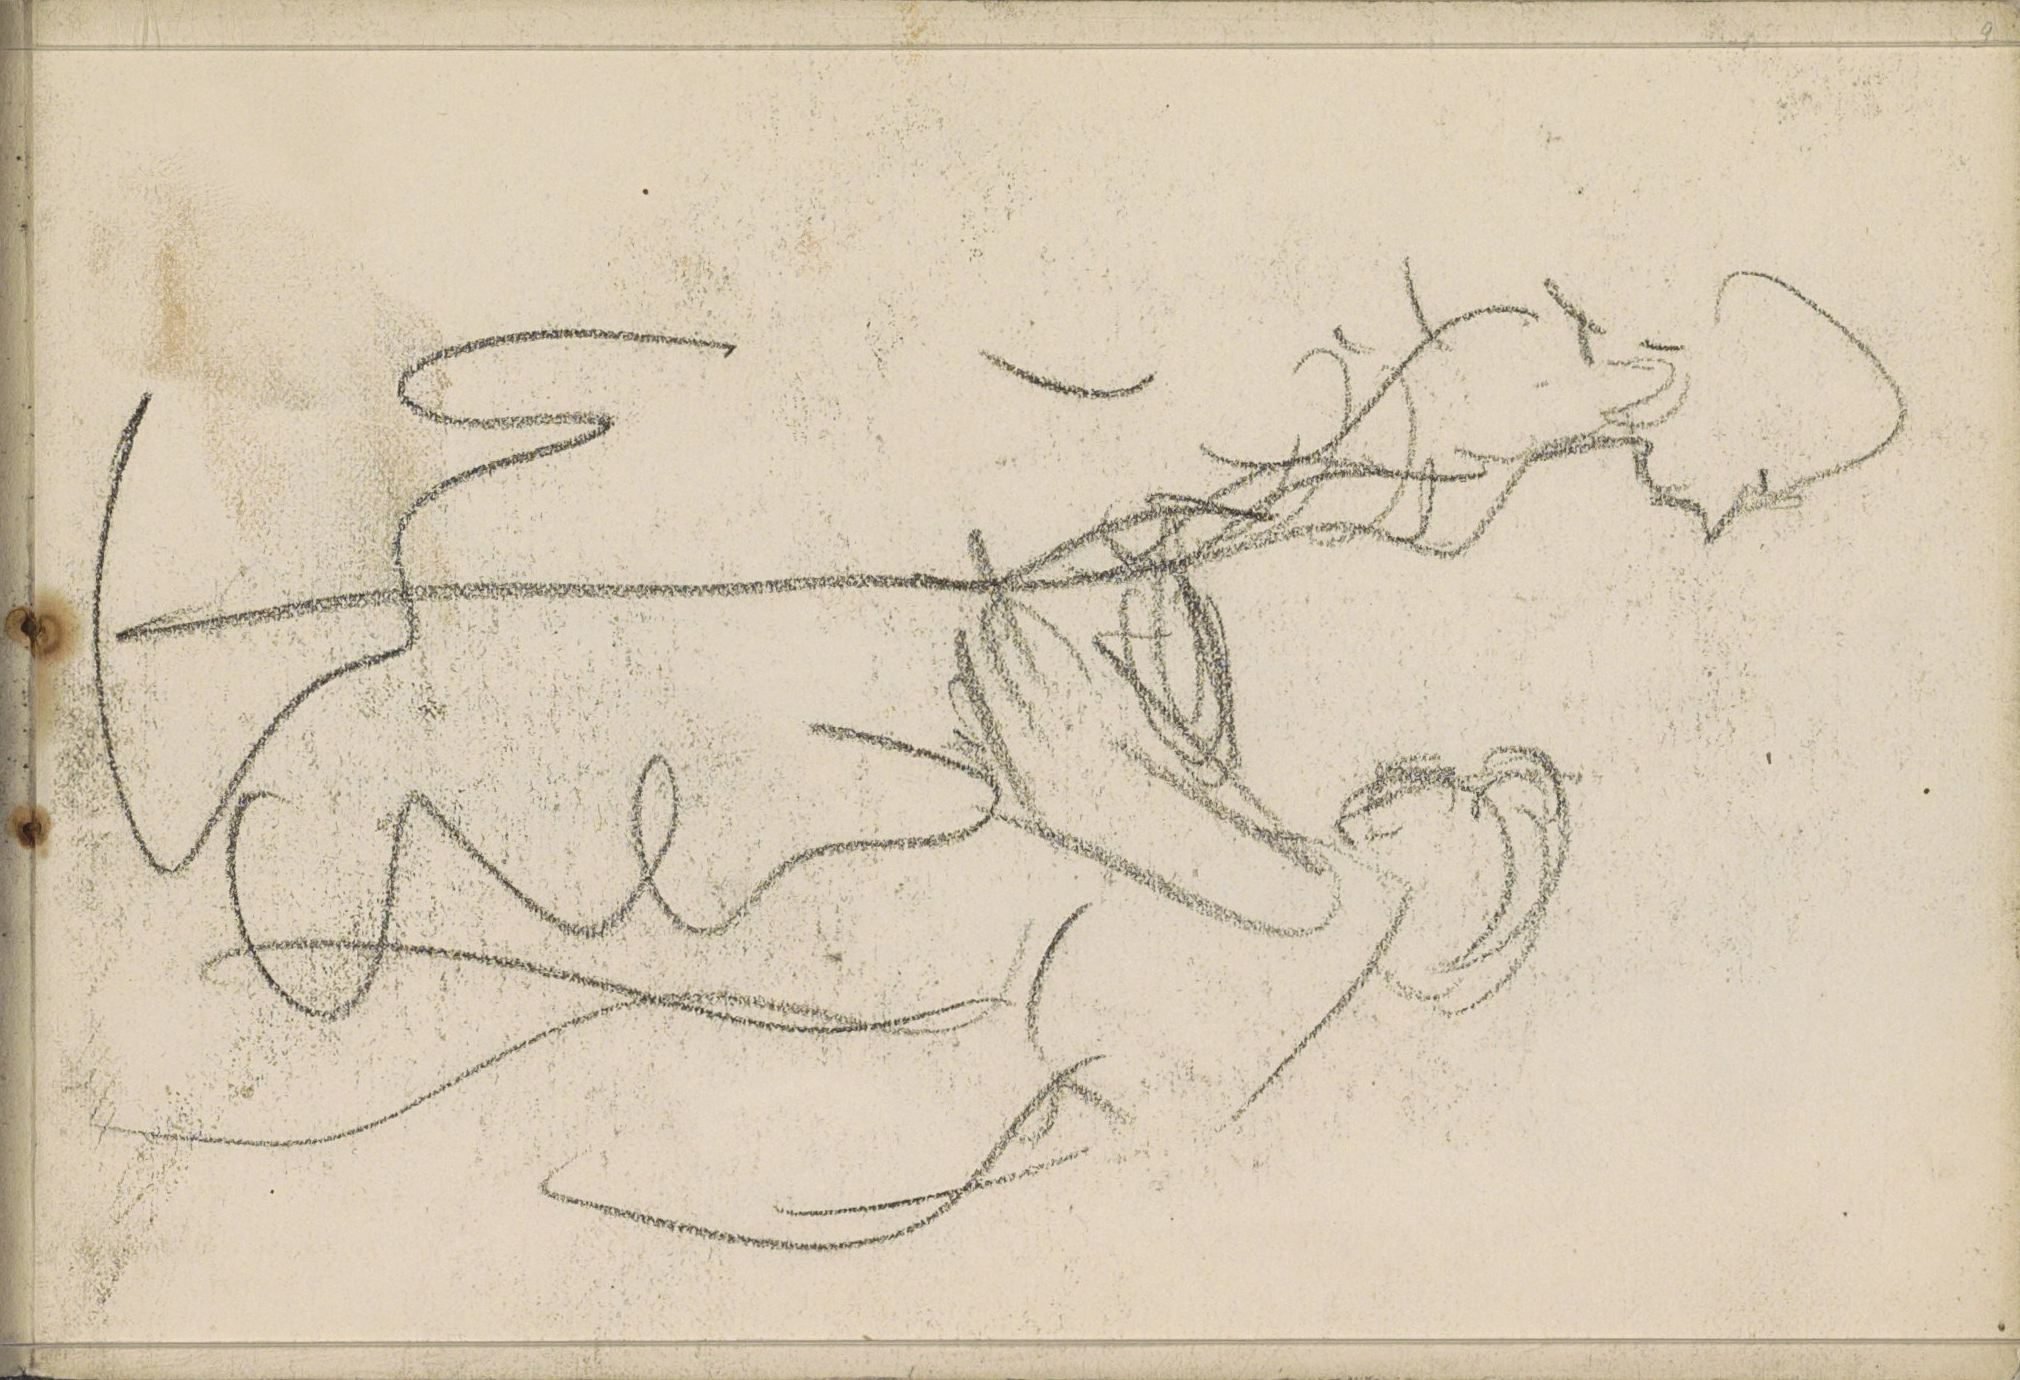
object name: sketchbook leaf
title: Twee staande figuren tegenover elkaar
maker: isaac israels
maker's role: draughtsman, painter, print maker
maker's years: 1865-1934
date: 1875-1934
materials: chalk, paper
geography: the hague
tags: dressing someone else - aa - female human figure, adult woman (+ standing)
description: Mogelijk een kleedster die met de kleding van een vrouw bezig is. Pagina 9 uit schetsboek XLII met 32 pagina's.